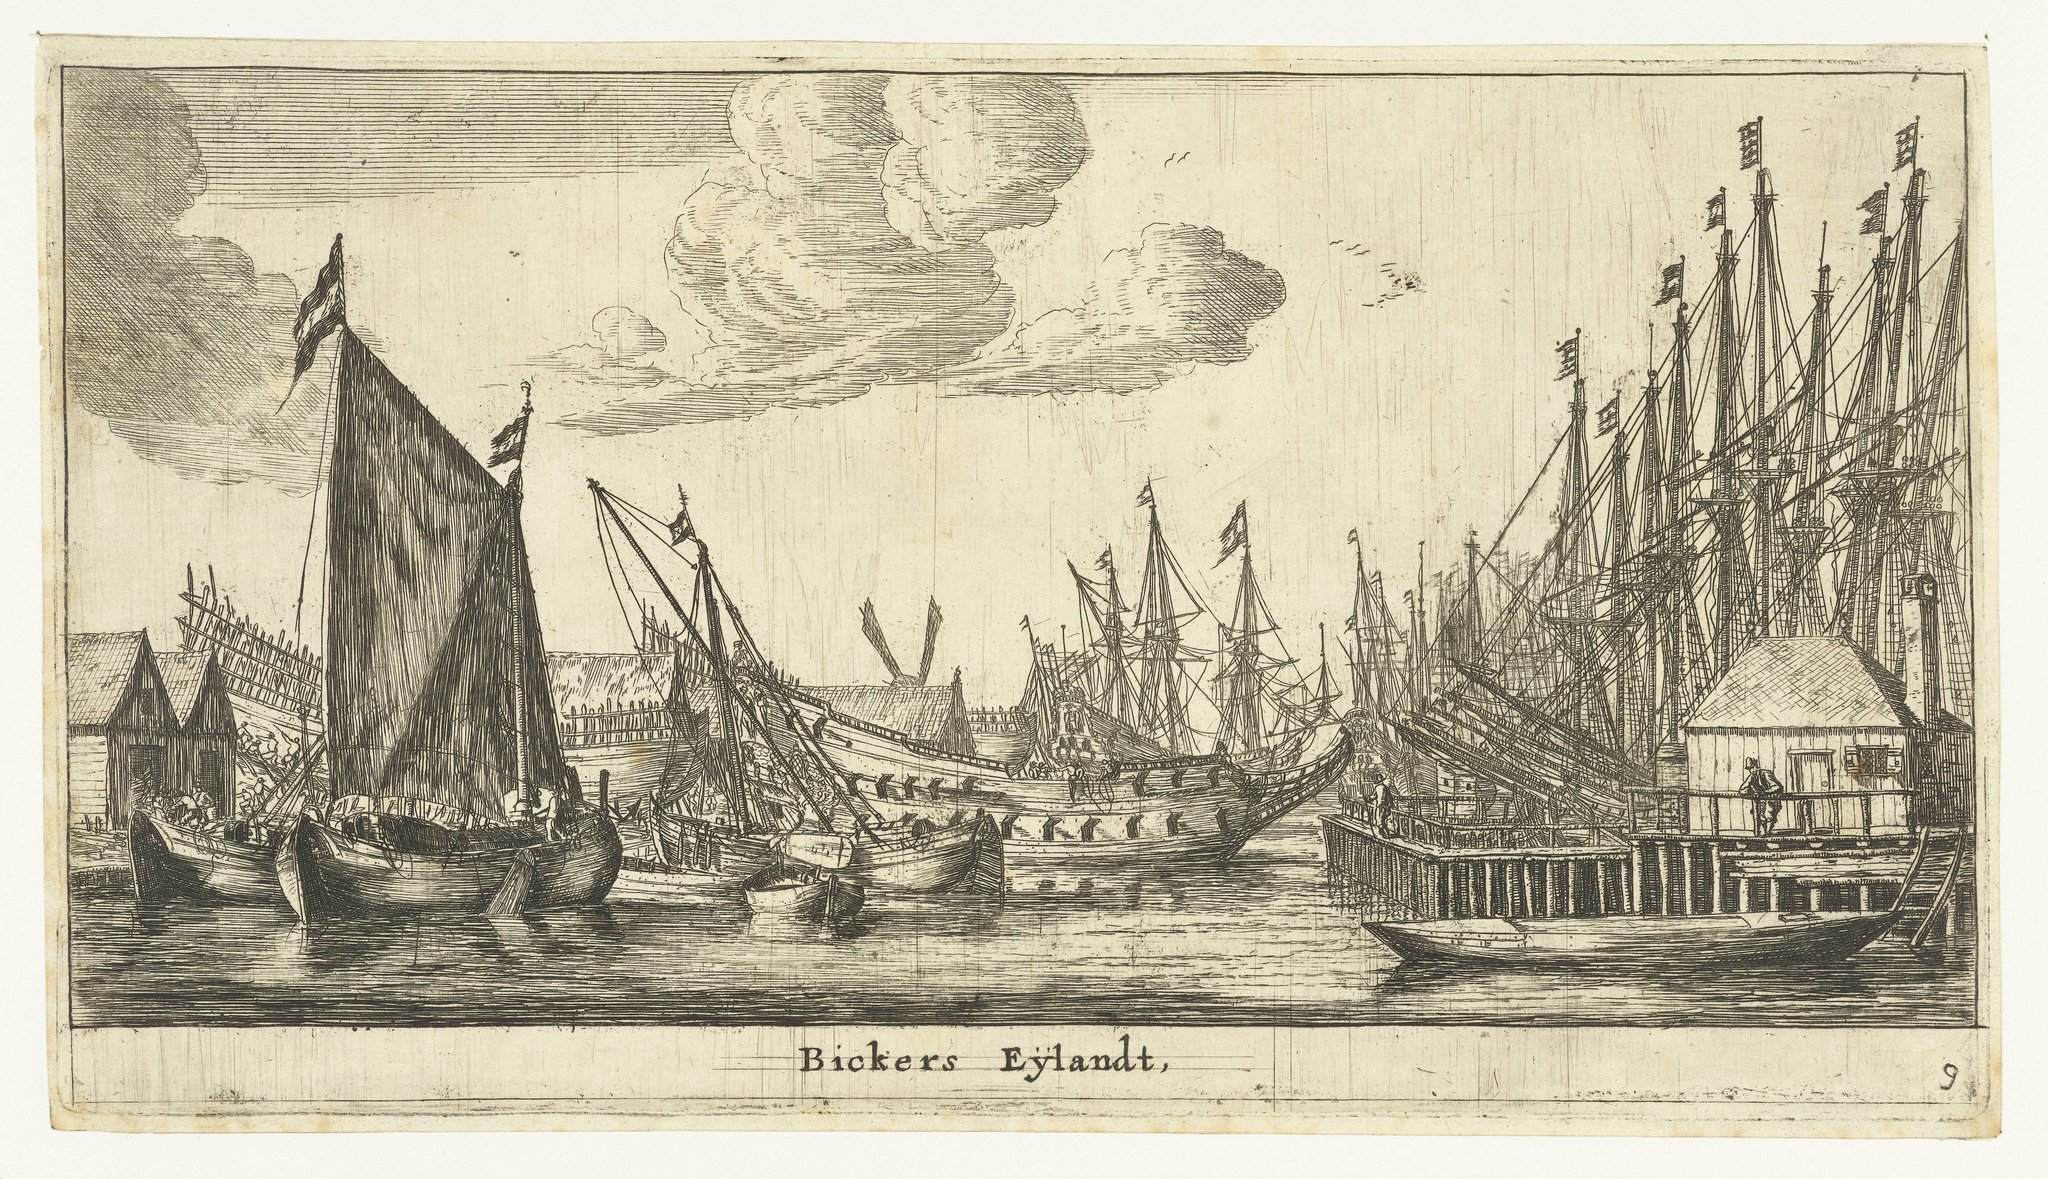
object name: print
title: Eerste deel. Verscheÿde schepen en gesichten van Amstelredam, naer t leven afgetekent en opt cooper gebracht, door Reinier Nooms, alÿas Zeeman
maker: reinier nooms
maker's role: draughtsman, painter, print maker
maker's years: 1623-1664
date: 1652-1654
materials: paper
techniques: drypoint, etching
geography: netherlands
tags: mayor, sailing-ship, sailing-boat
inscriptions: collector's mark: Lugt 12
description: Bickerseiland in Amsterdam. Boten in de haven. Links de werf van Jan Bicker.